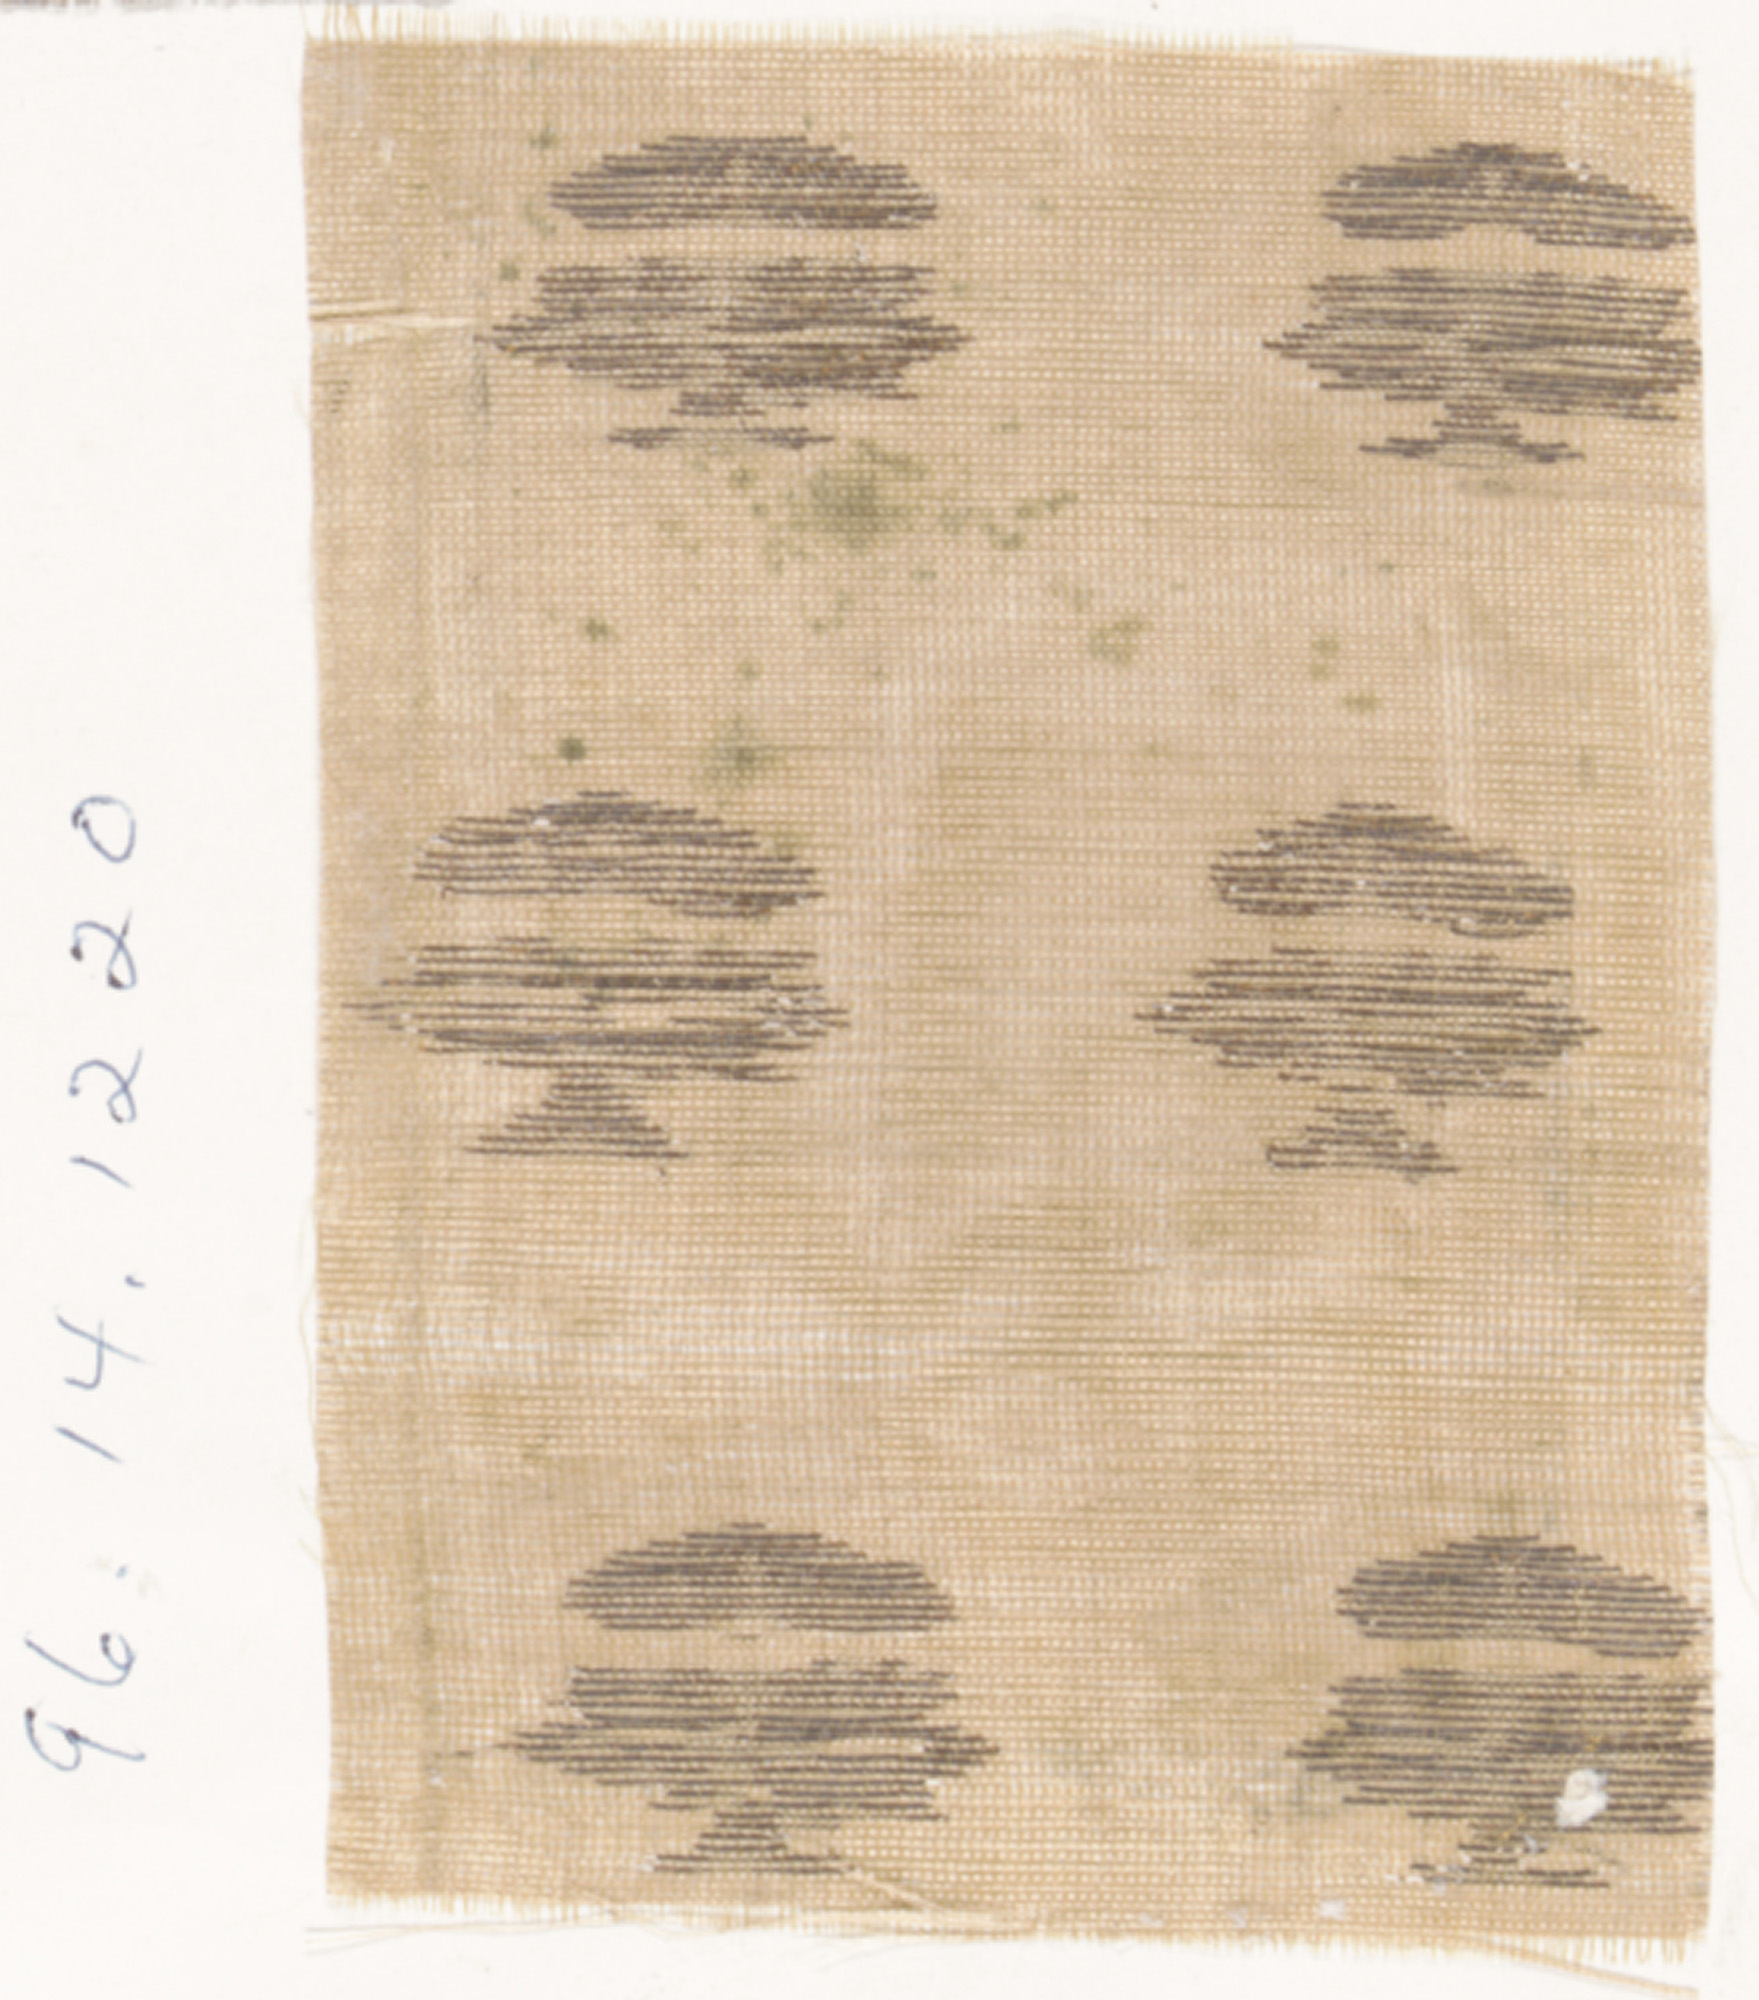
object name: piece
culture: japanese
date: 1701-1900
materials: silk